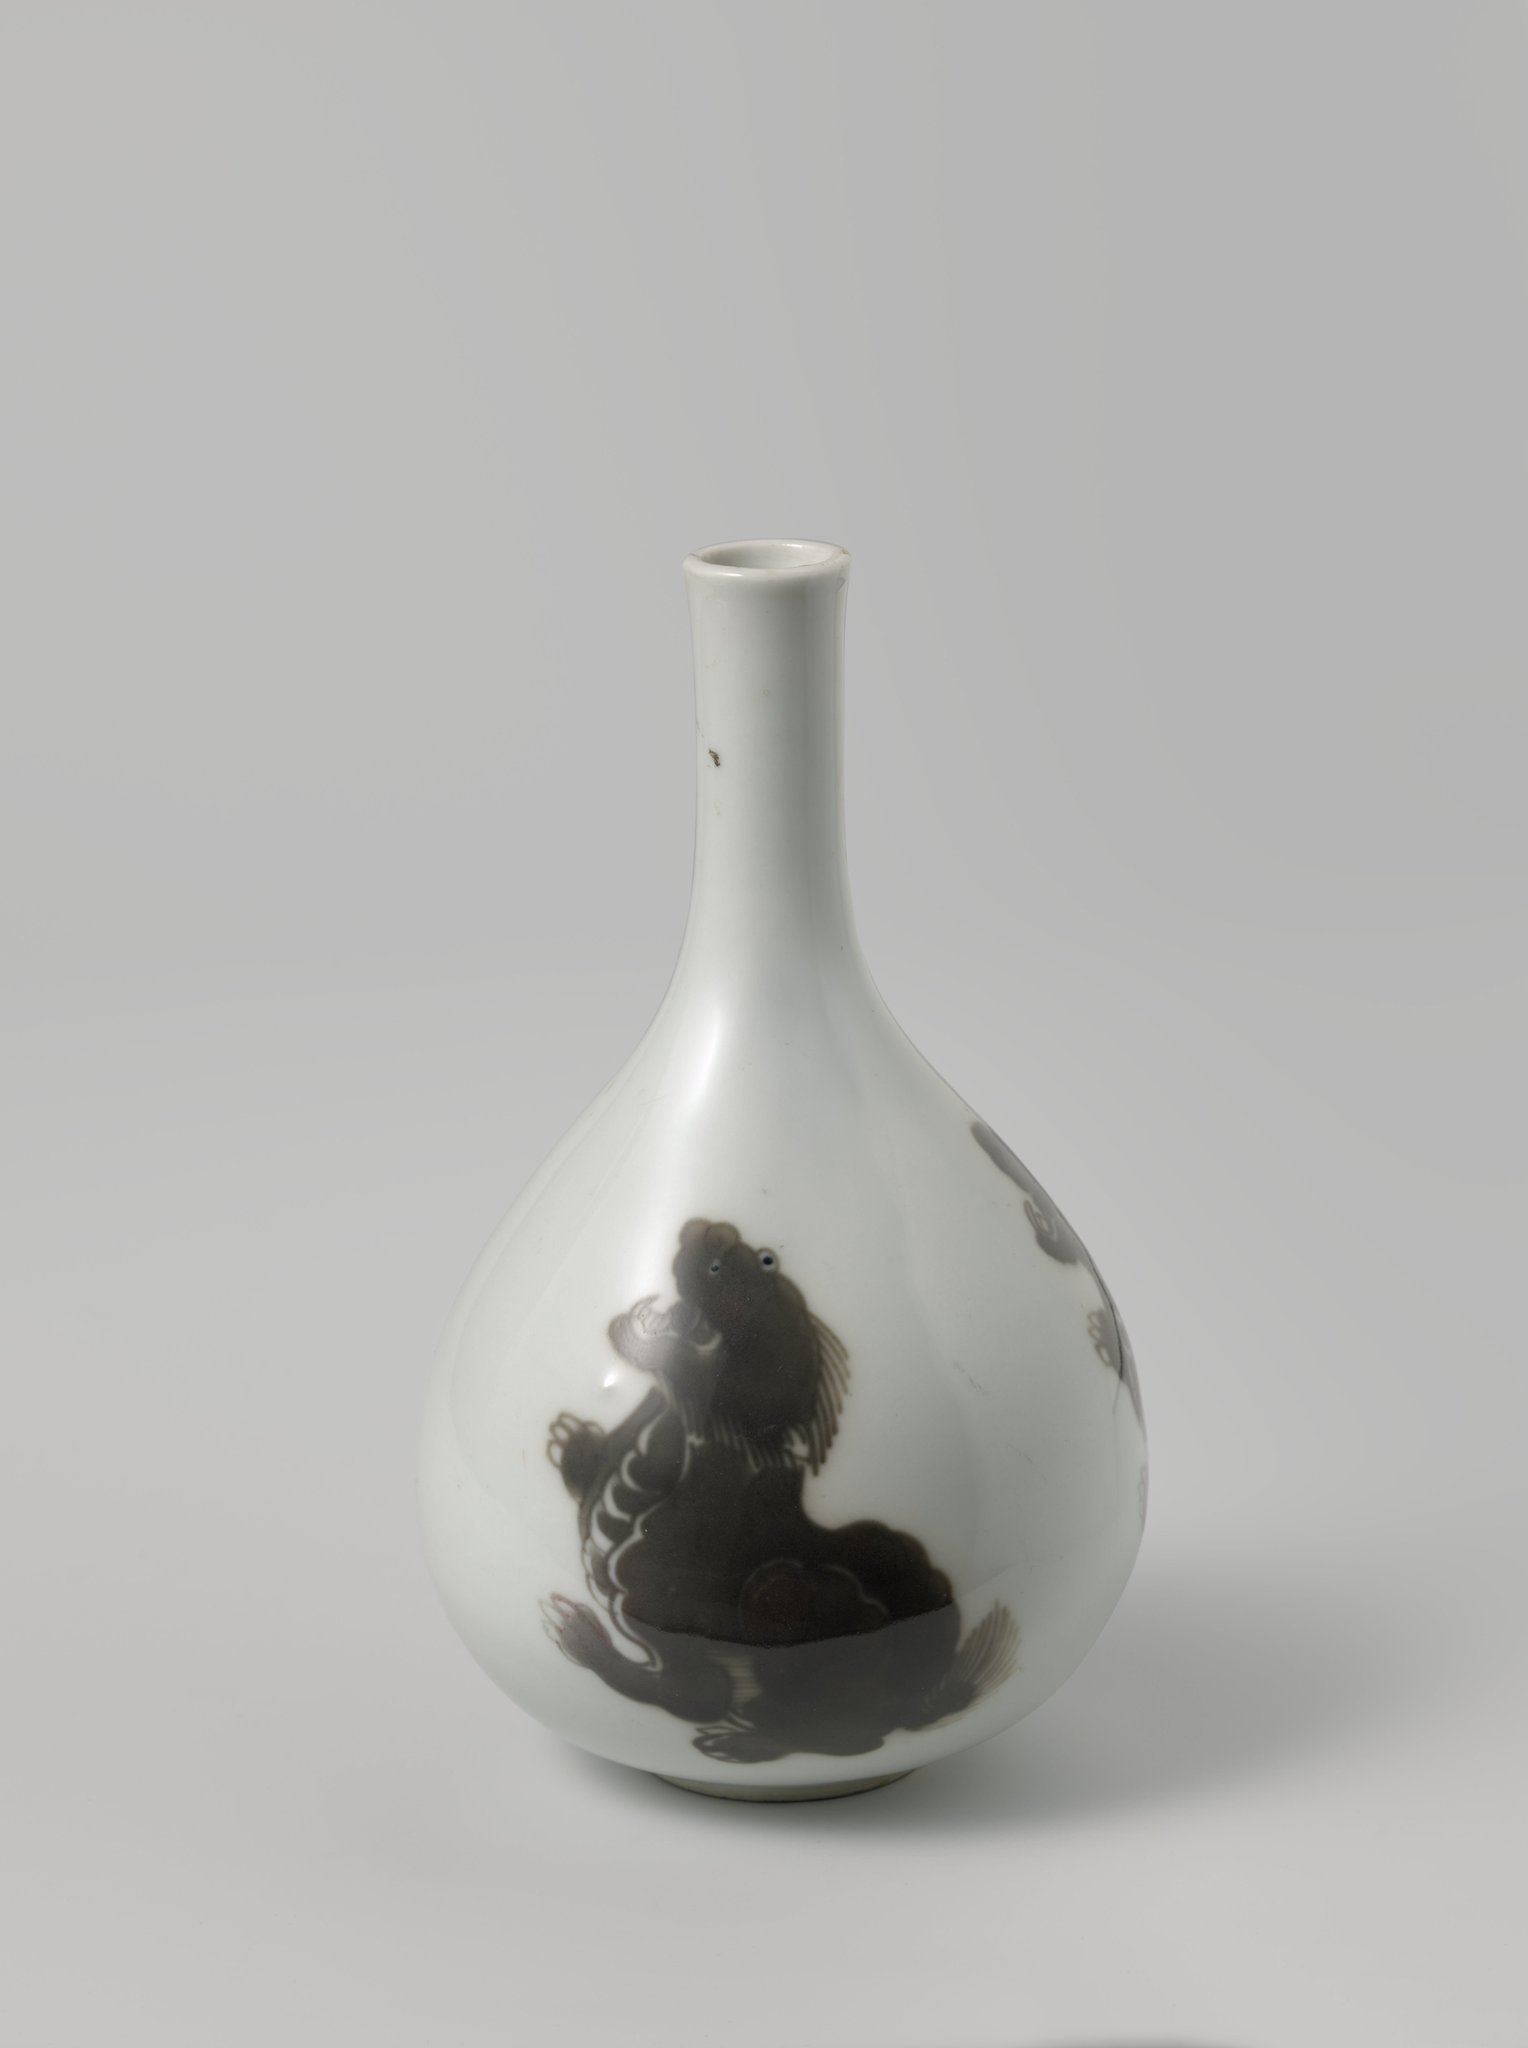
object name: vase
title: Pear-shaped bottle vase with three shishi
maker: Anonymous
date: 1700-1724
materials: cobalt, copper, glaze, paint, porcelain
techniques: firing, turning, vitrification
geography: china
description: Flesvormige vaas van porselein met peervormige buik en lange, rechte nek, beschilderd in onderglazuur blauw en rood. Op de wand driemaal een shishi (leeuwhond), bijna volledig zwart. Onderglazuur blauw en koperrood.